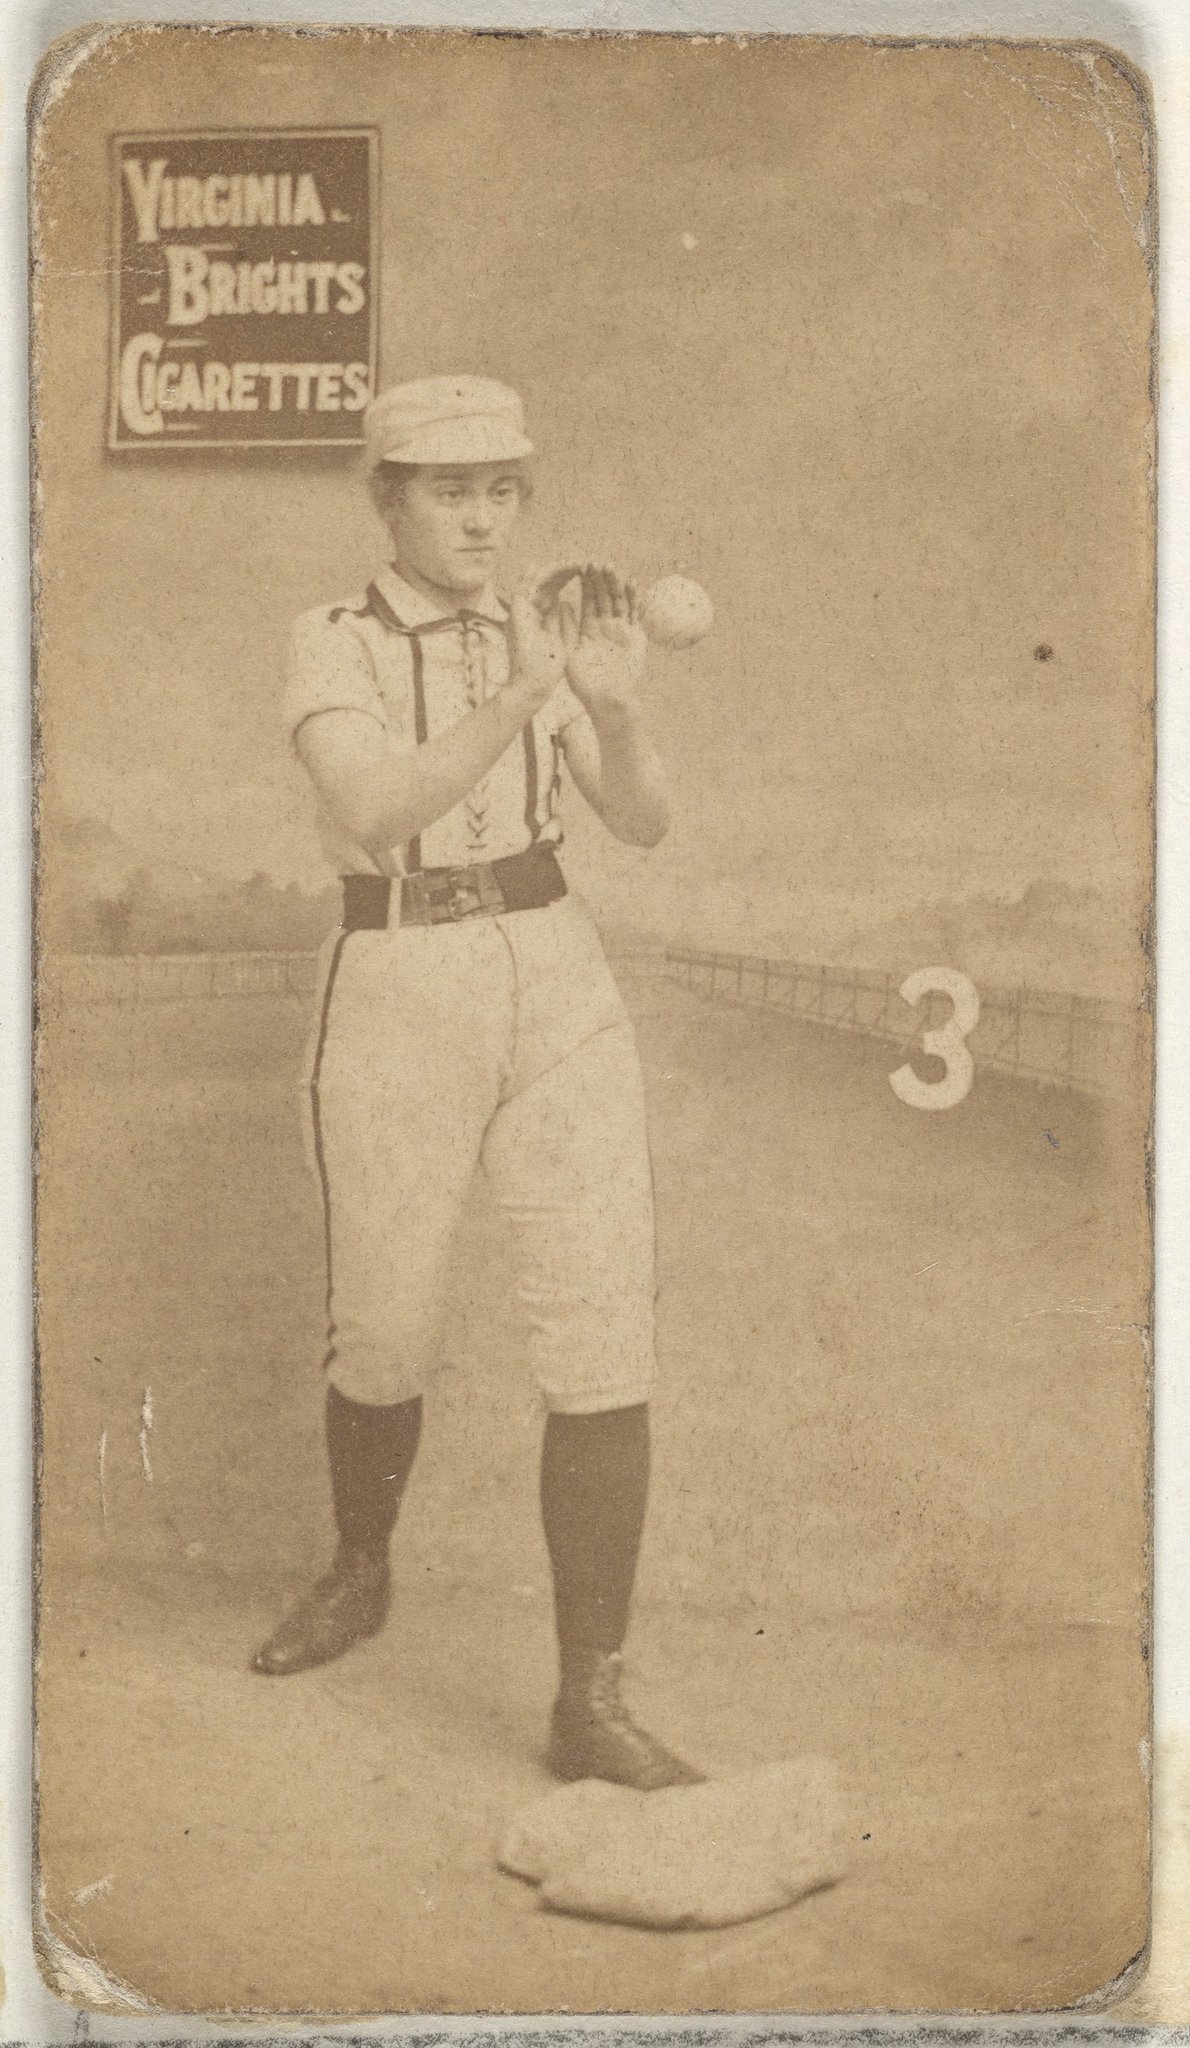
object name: baseball card, photograph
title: Card 3, from the Girl Baseball Players series (N48, Type 2) for Virginia Brights Cigarettes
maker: allen & ginter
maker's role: publisher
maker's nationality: american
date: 1886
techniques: albumen silver print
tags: portraits,women,baseball,athletes